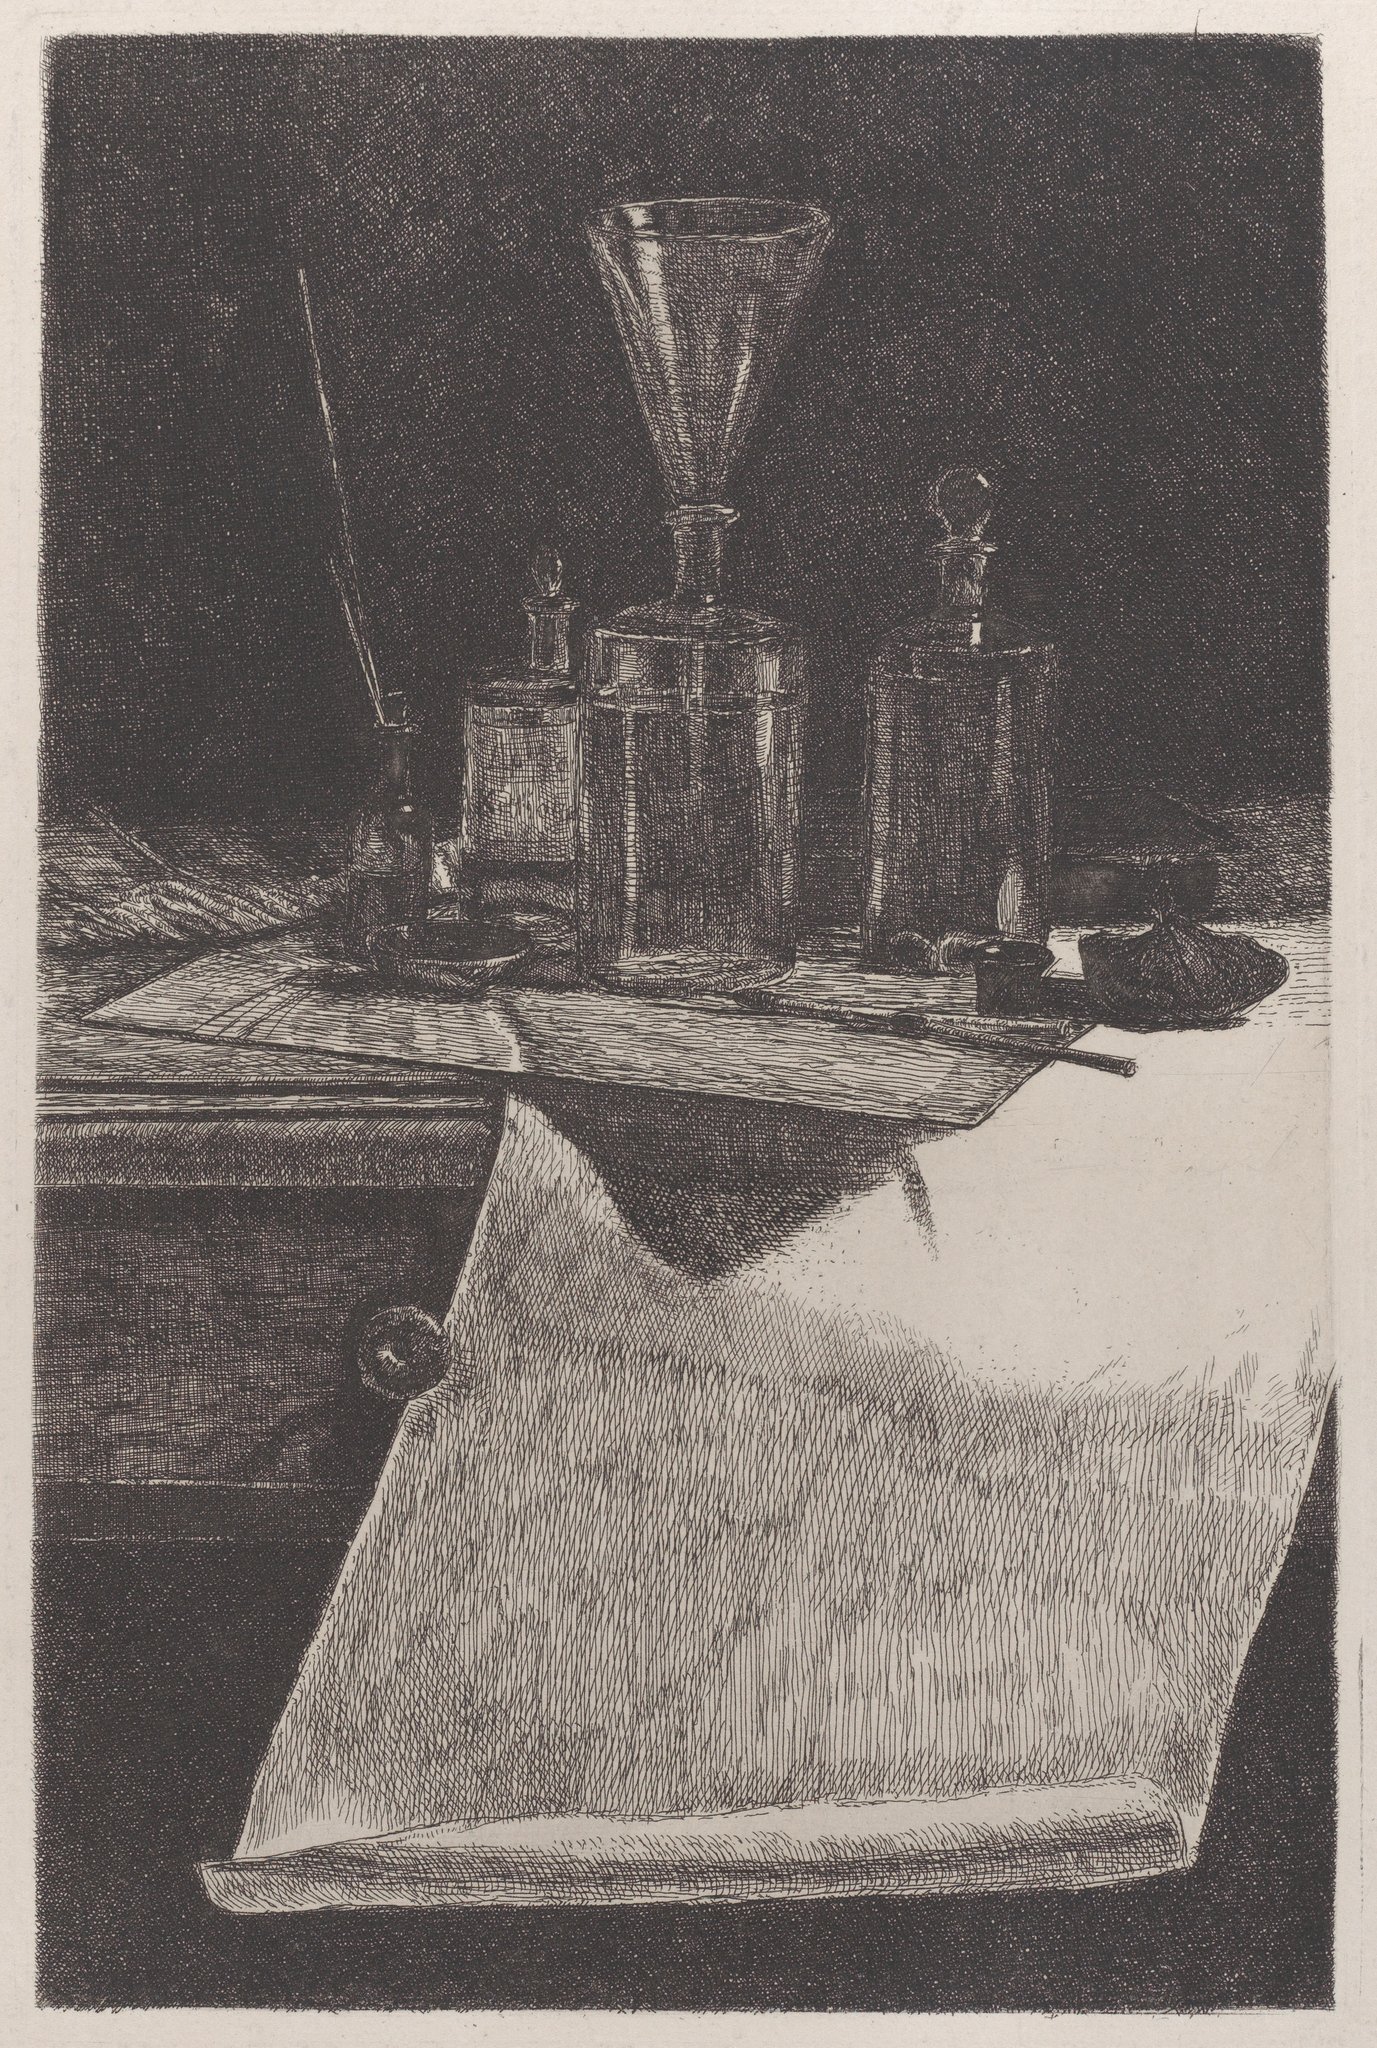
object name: print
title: Etching Tools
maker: françois bonvin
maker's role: artist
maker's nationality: french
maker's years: 1817-1887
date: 1861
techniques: etching